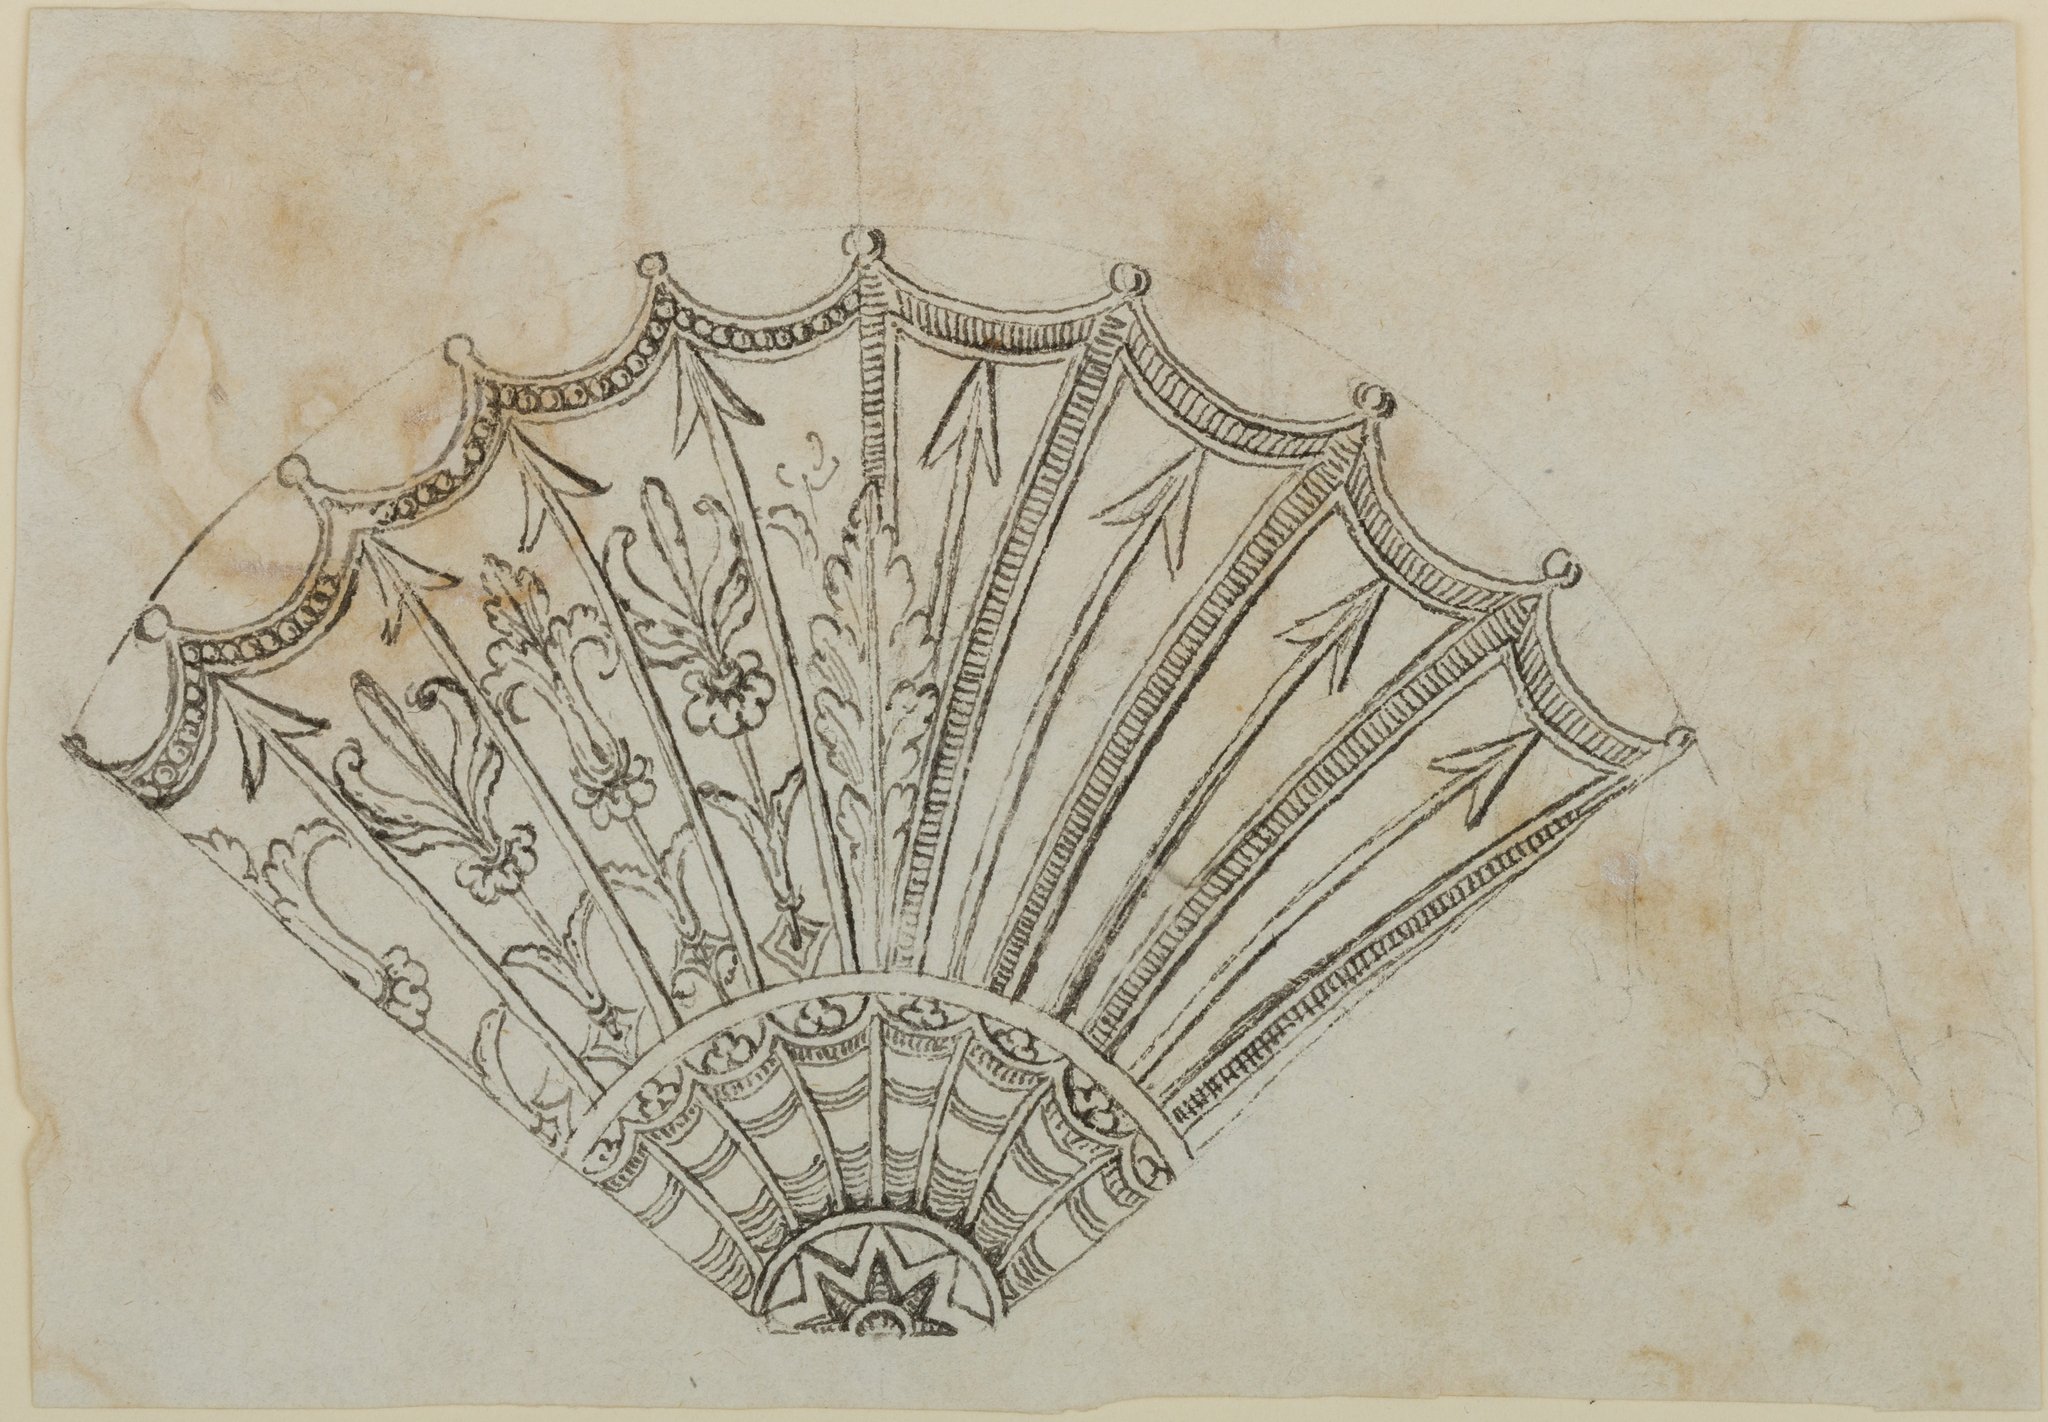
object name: drawing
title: Design for the Decoration of Firearms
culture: french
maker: nicolas noël boutet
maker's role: designer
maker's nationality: french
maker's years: 1761-1833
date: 1797-1805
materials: ink, paper, pencil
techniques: wash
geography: france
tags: ornament